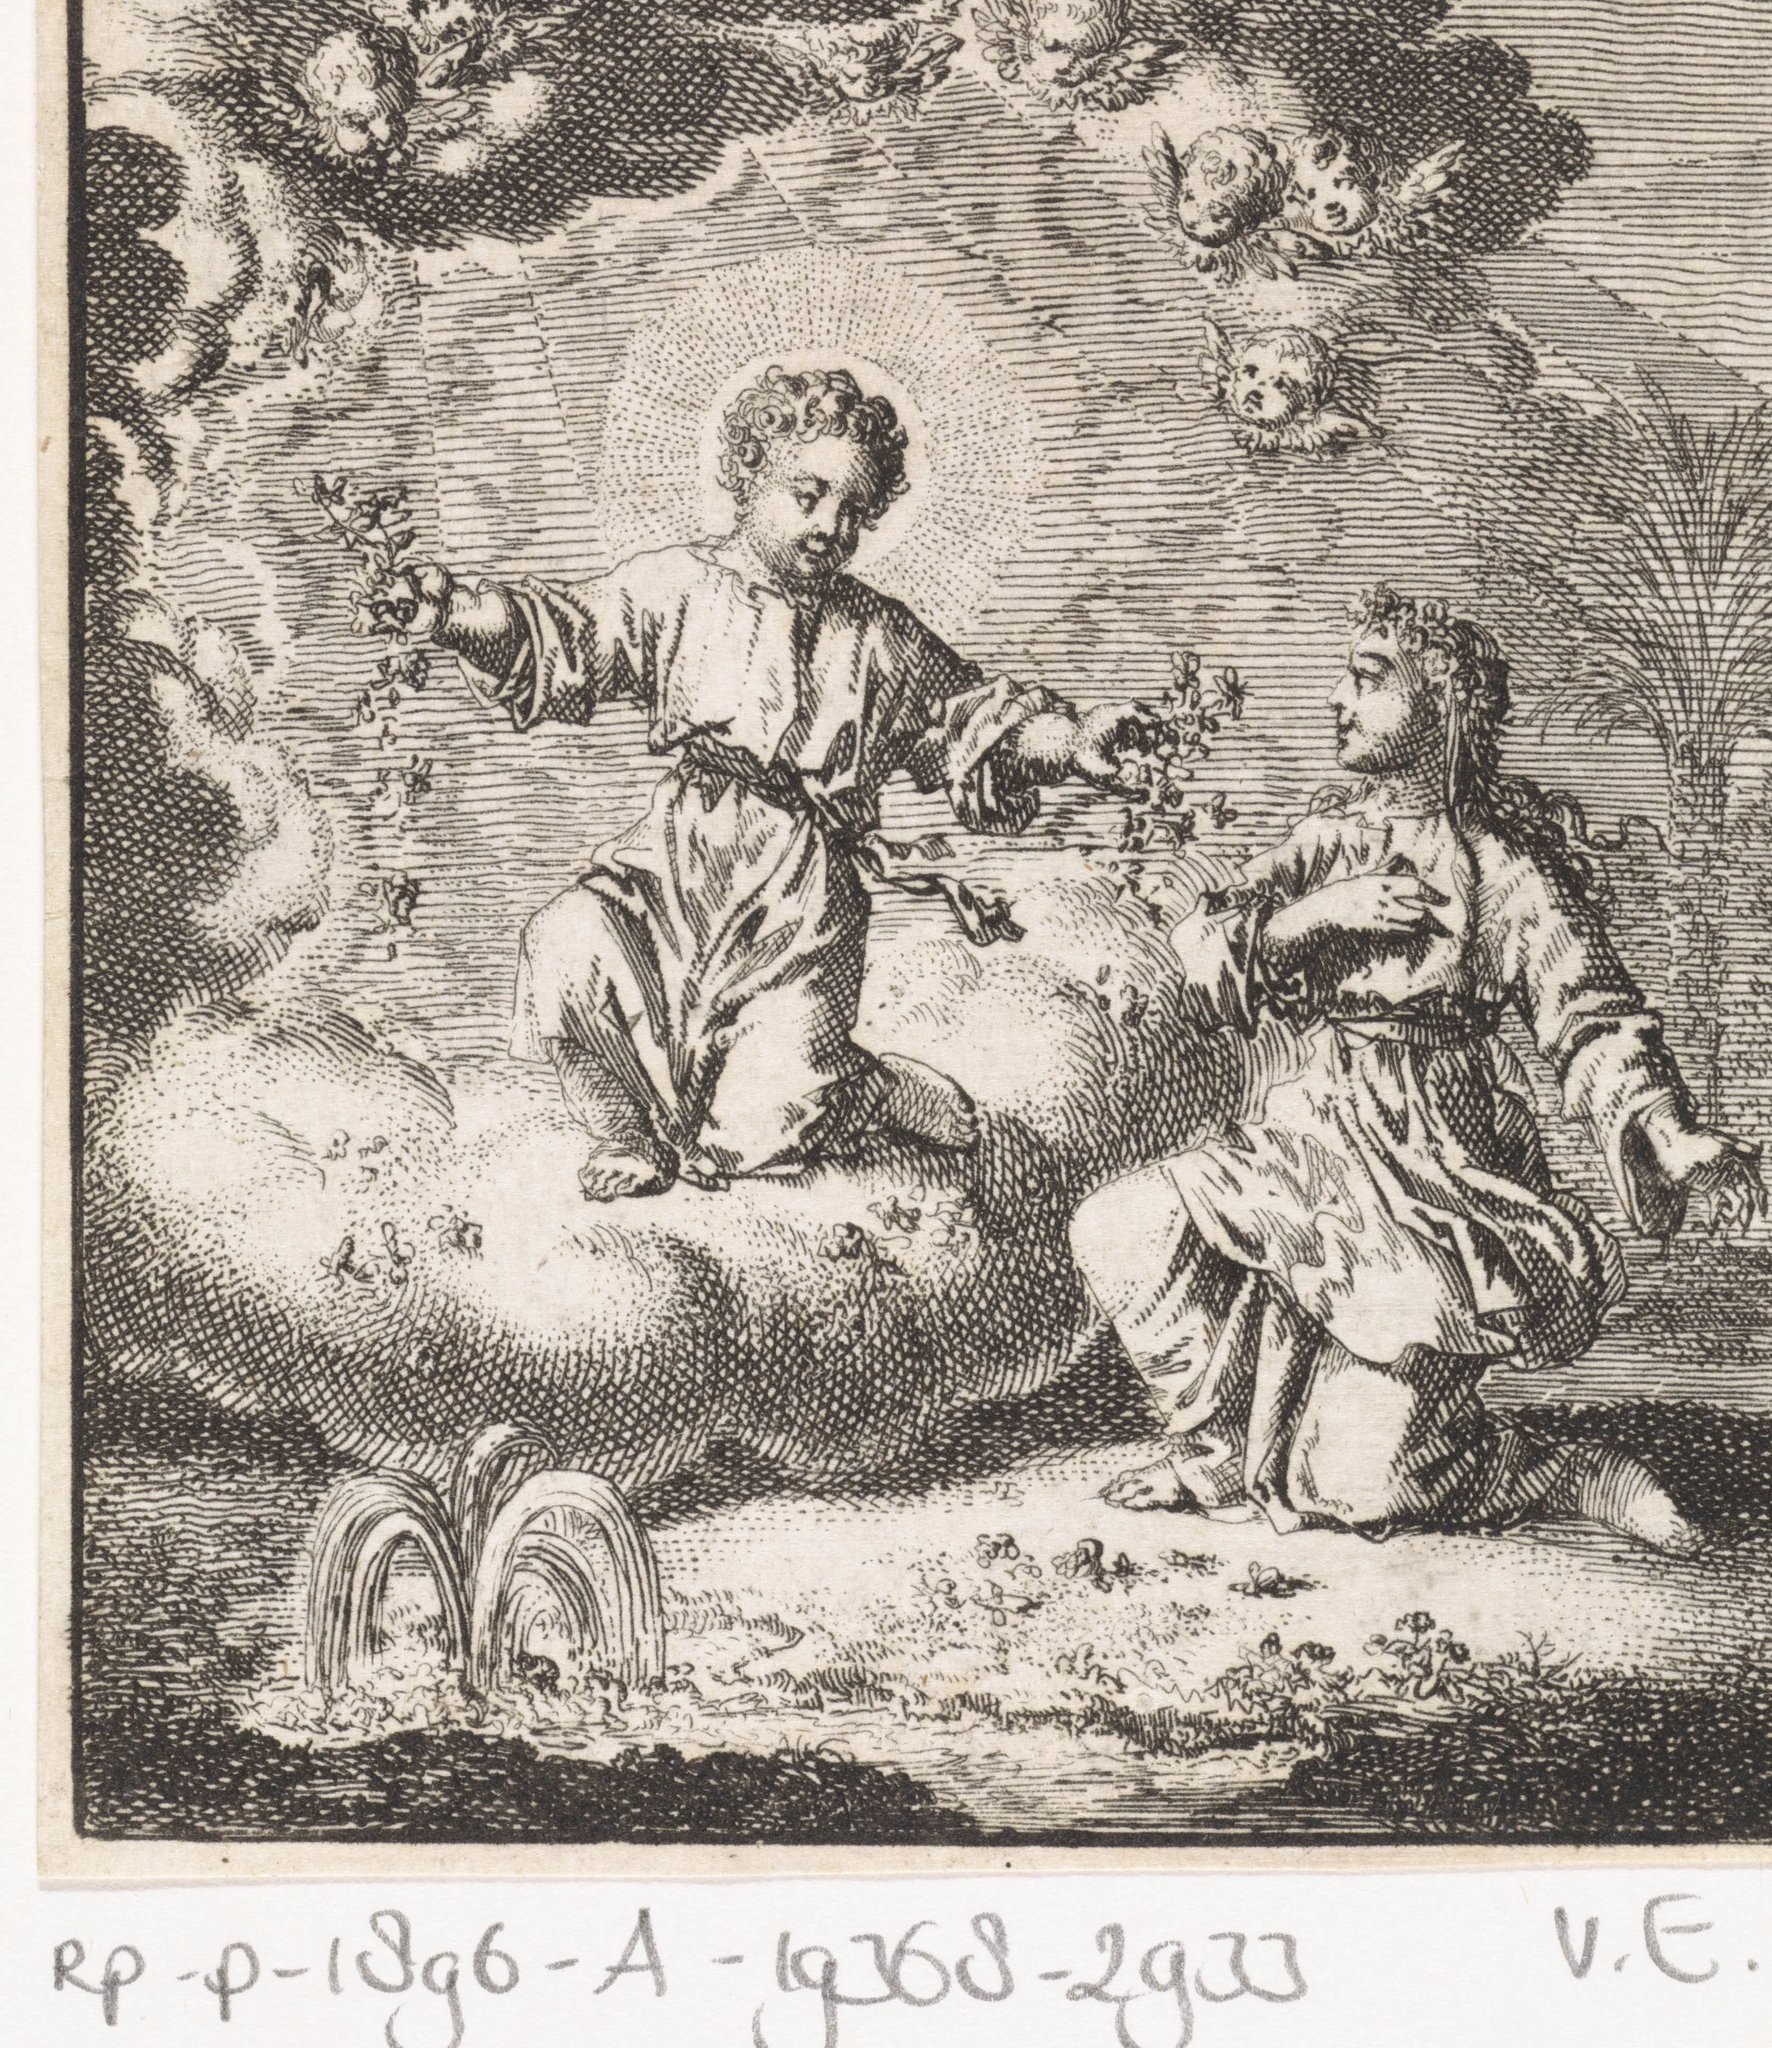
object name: print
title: De Ziel wordt door Jezus ontmoet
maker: jan luyken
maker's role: draughtsman, print maker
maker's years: 1649-1712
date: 1714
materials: paper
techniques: etching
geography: amsterdam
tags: christ and the soul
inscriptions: collector's mark: Lugt 2228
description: Proefdruk van illustratie uit: Luyken, Jan. Jezus en de Ziel, 3 delen. Amsterdam: Wed. Pieter Arentsz II en Cornelis van der Sys, 1714, dl. I, p. 35.